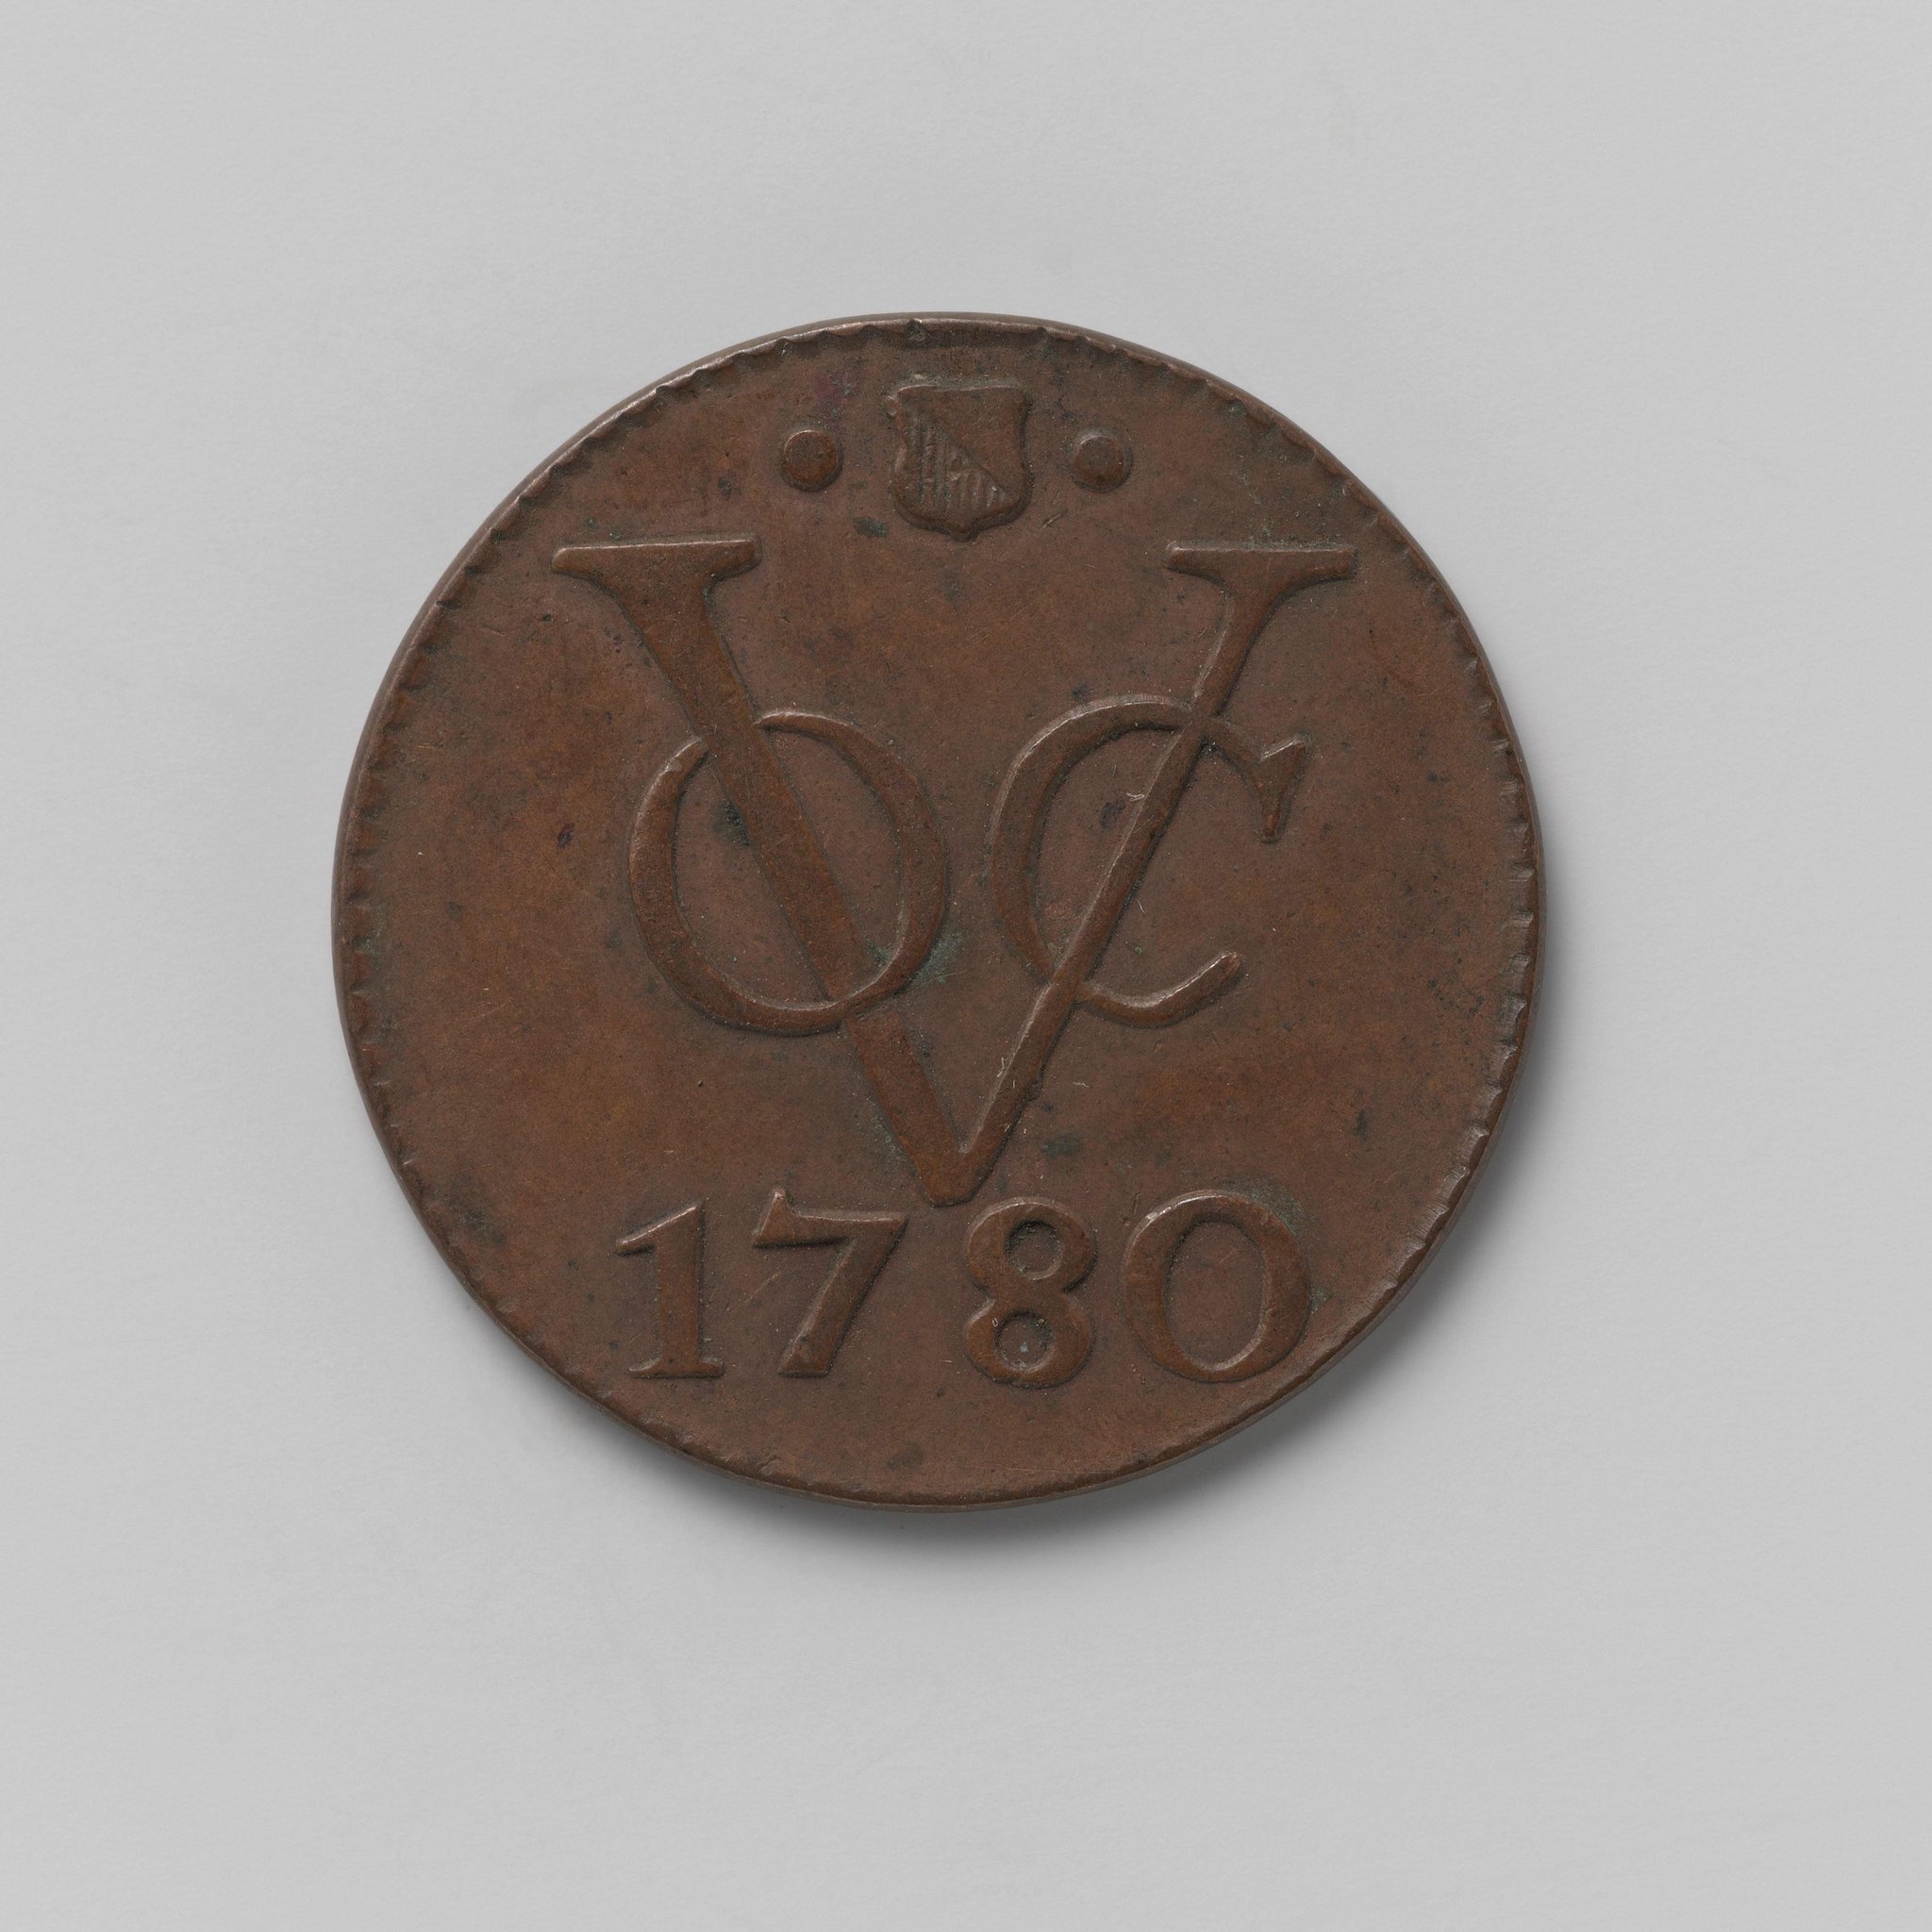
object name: coin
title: VOC, duit stad Utrecht,1780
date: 1780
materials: copper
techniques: striking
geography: utrecht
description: Koperen munt. Voorzijde: op balk, waaronder guirlande, geplaatst, door twee leeuwen gehouden gekroond wapenschild van de stad Utrecht. Keerzijde: monogram van de VOC, waarboven muntteken en waaronder jaartal. Gladde rand.